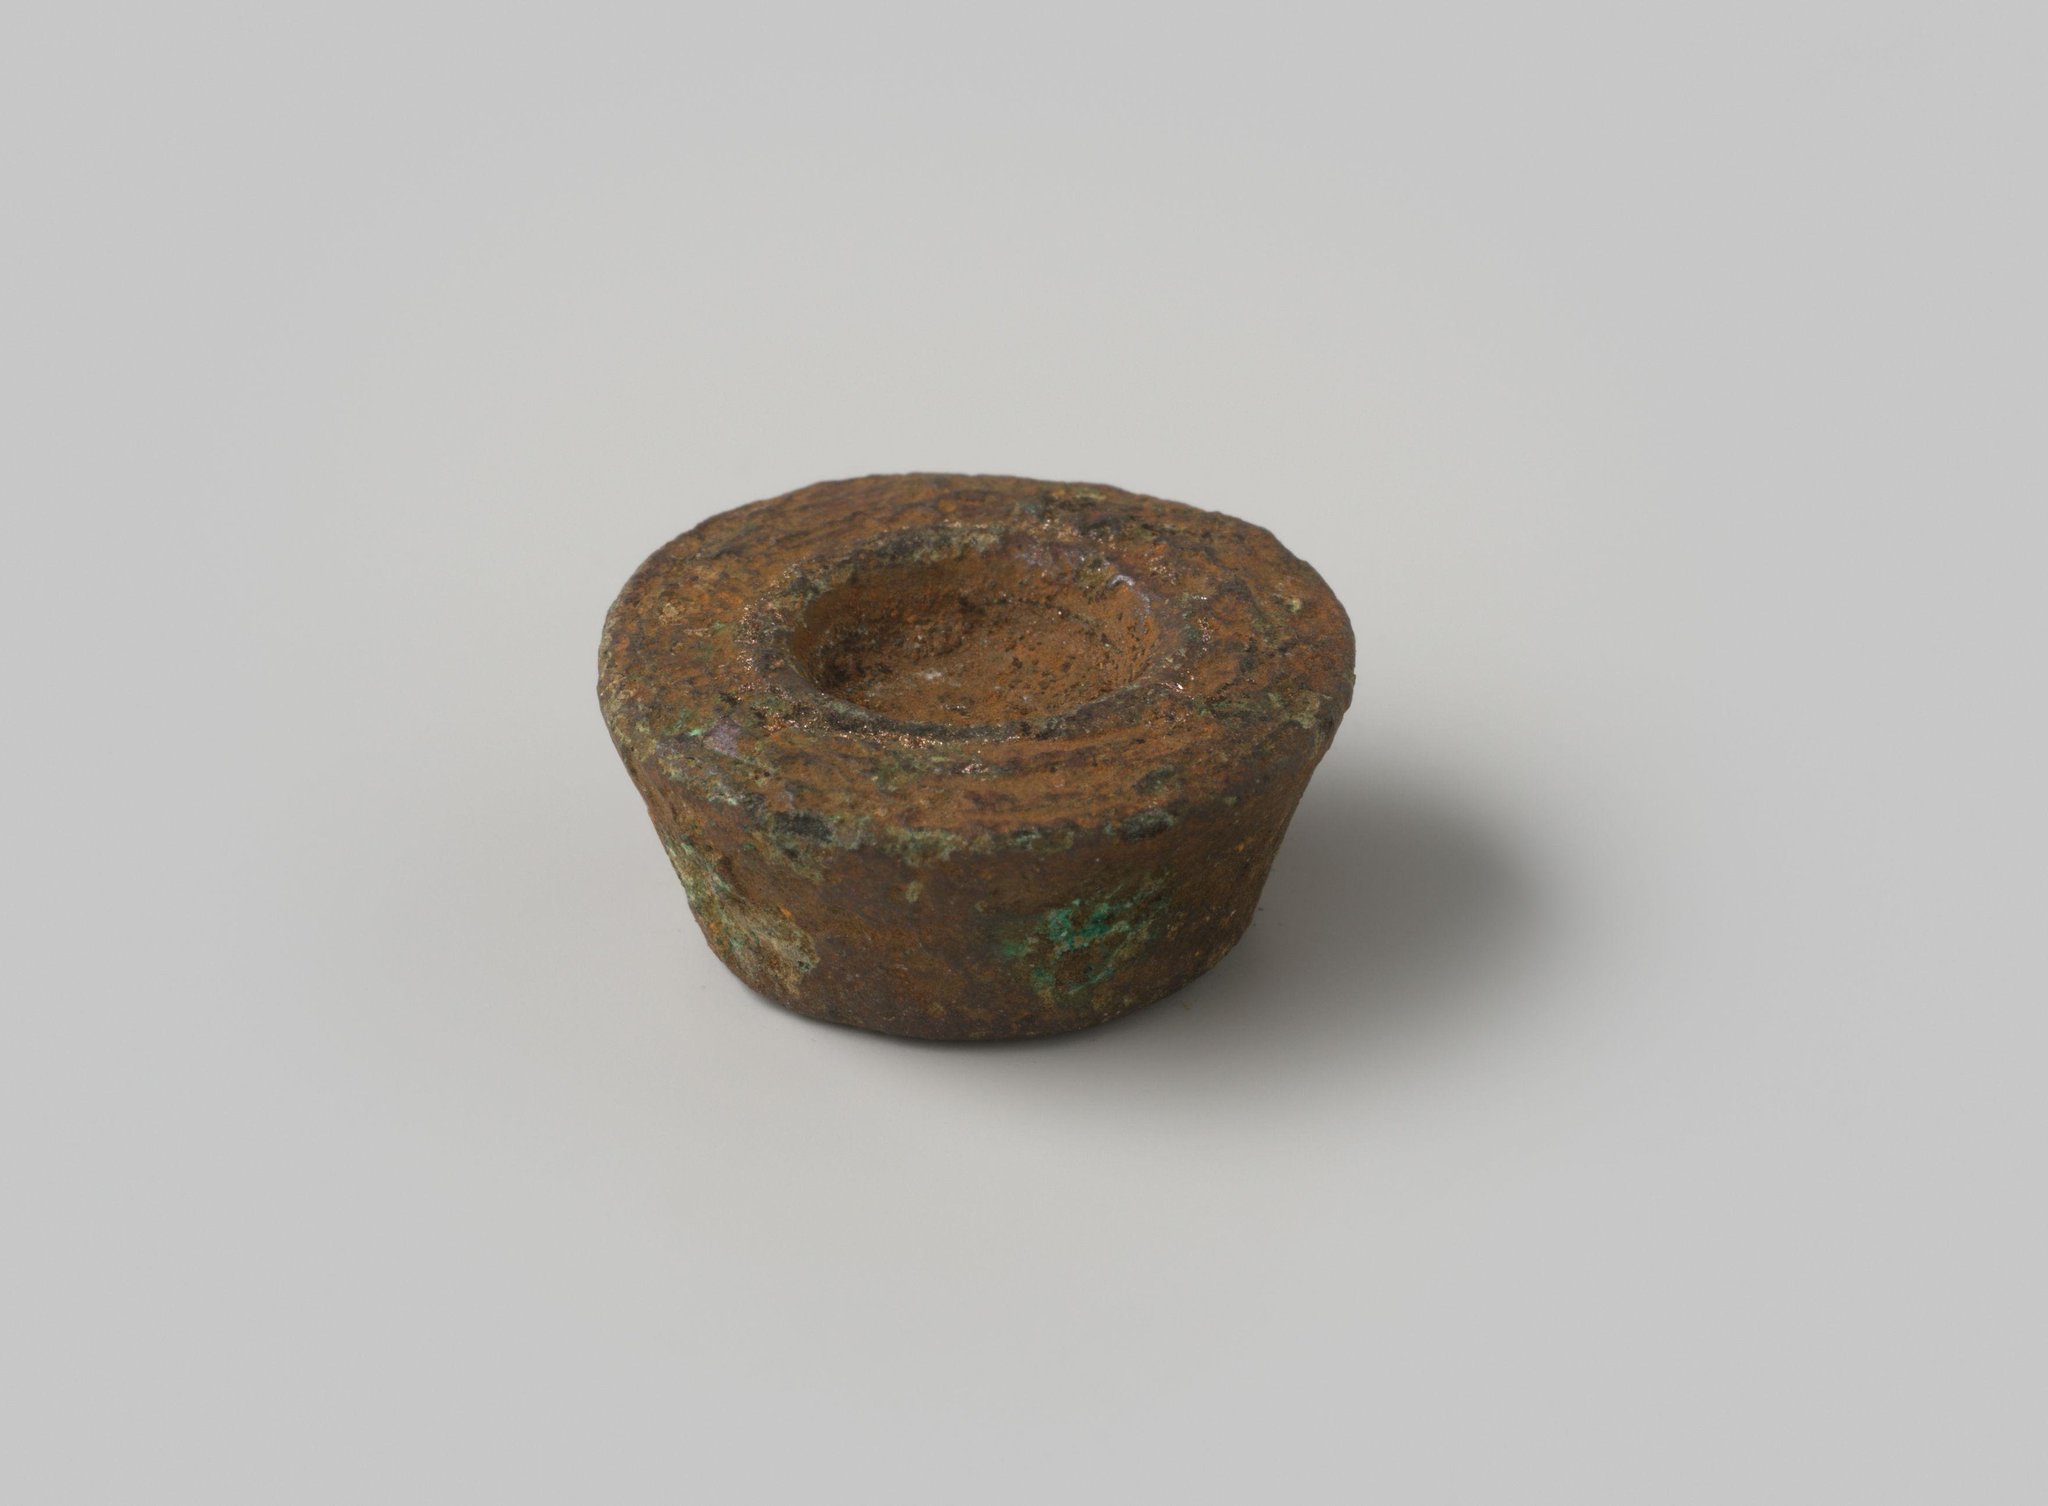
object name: weight scale component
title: Gewicht van sluitgewicht uit het wrak van de Oost-Indiëvaarder Hollandia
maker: Anonymous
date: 1700-1743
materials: copper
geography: netherlands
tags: verenigde oostindische compagnie, hollandia (schip), annet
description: Weight, cupweight, cup; id. NG 1980-27H2775, corroded together, no marks legible.